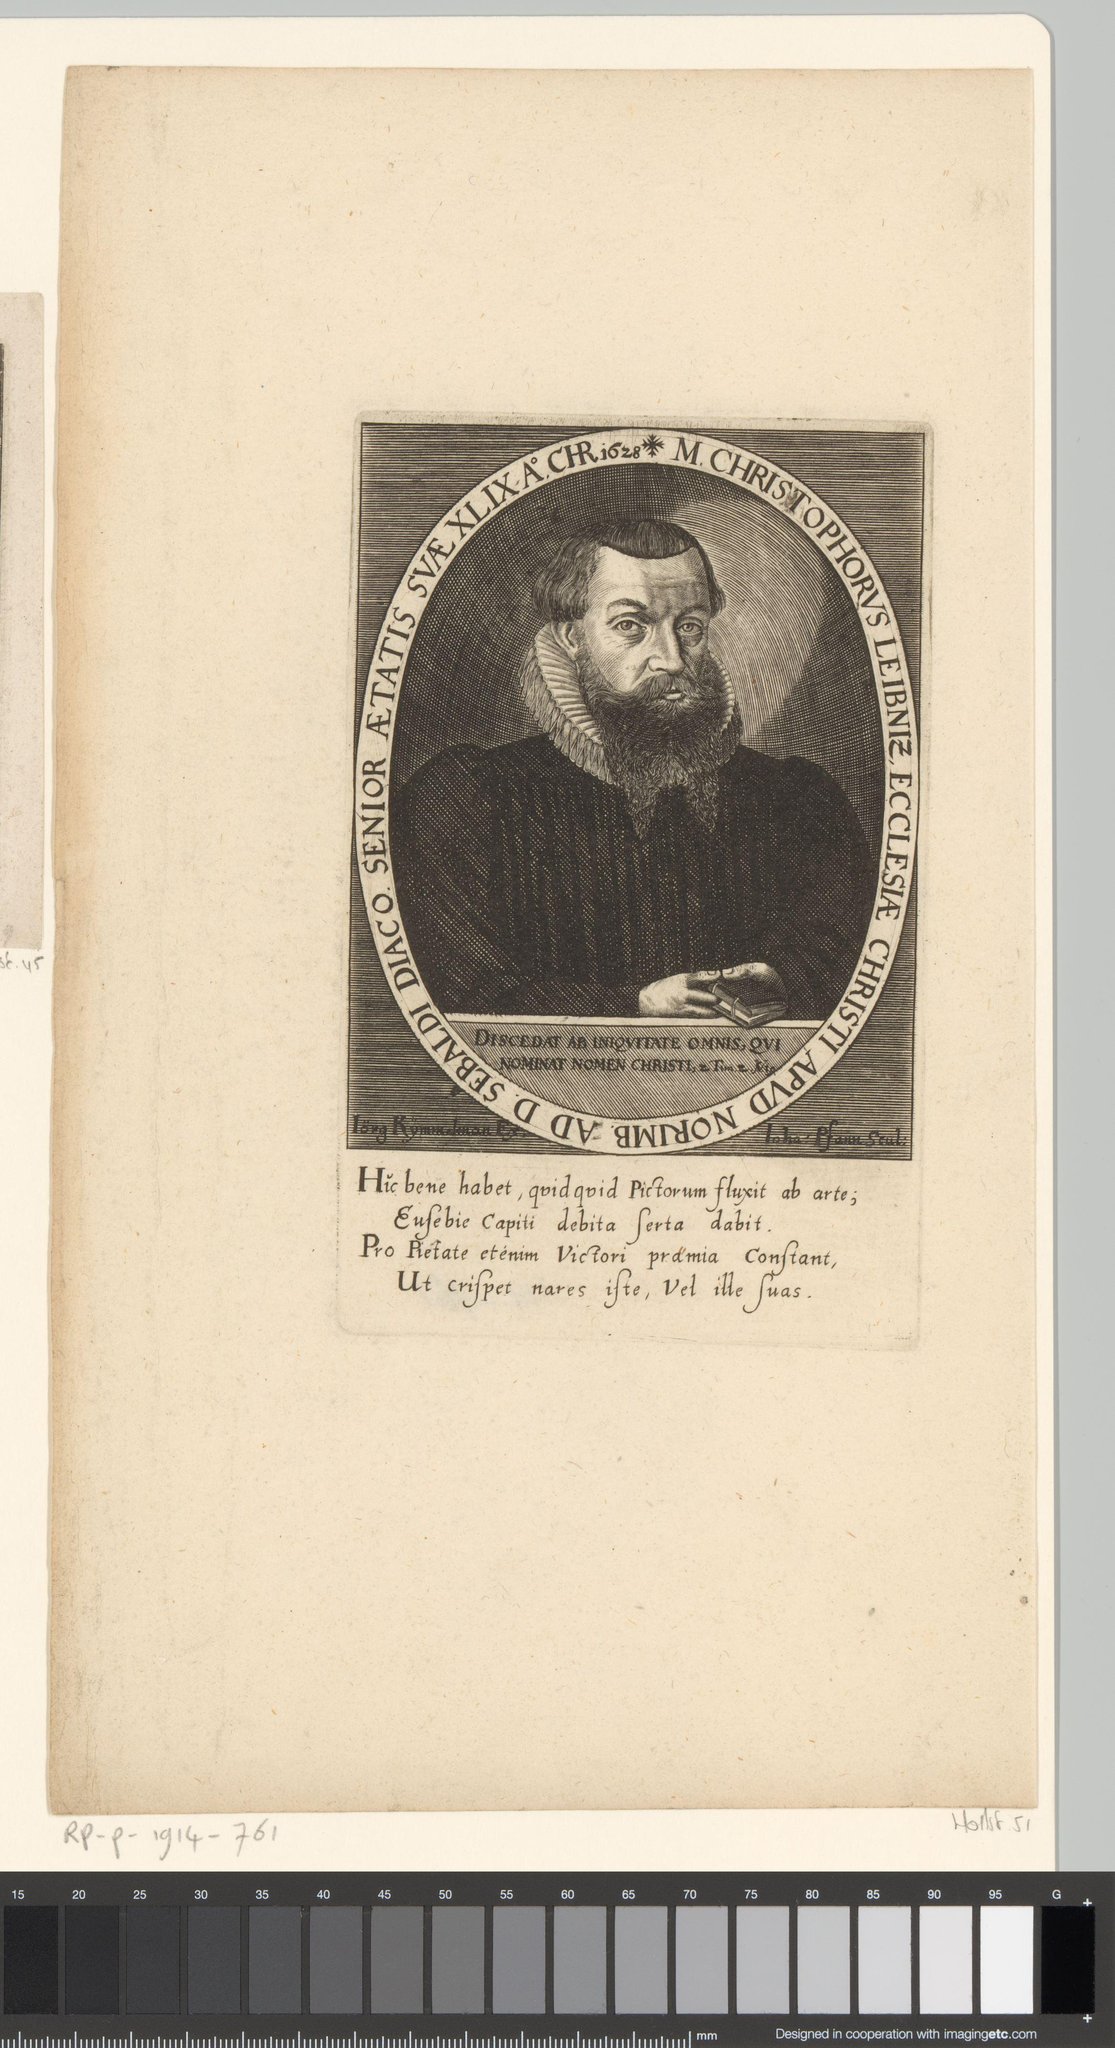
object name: print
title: Portret van Christoph Leibnitz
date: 1648-1663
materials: paper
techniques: engraving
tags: historical persons, book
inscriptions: collector's mark: Lugt 2228